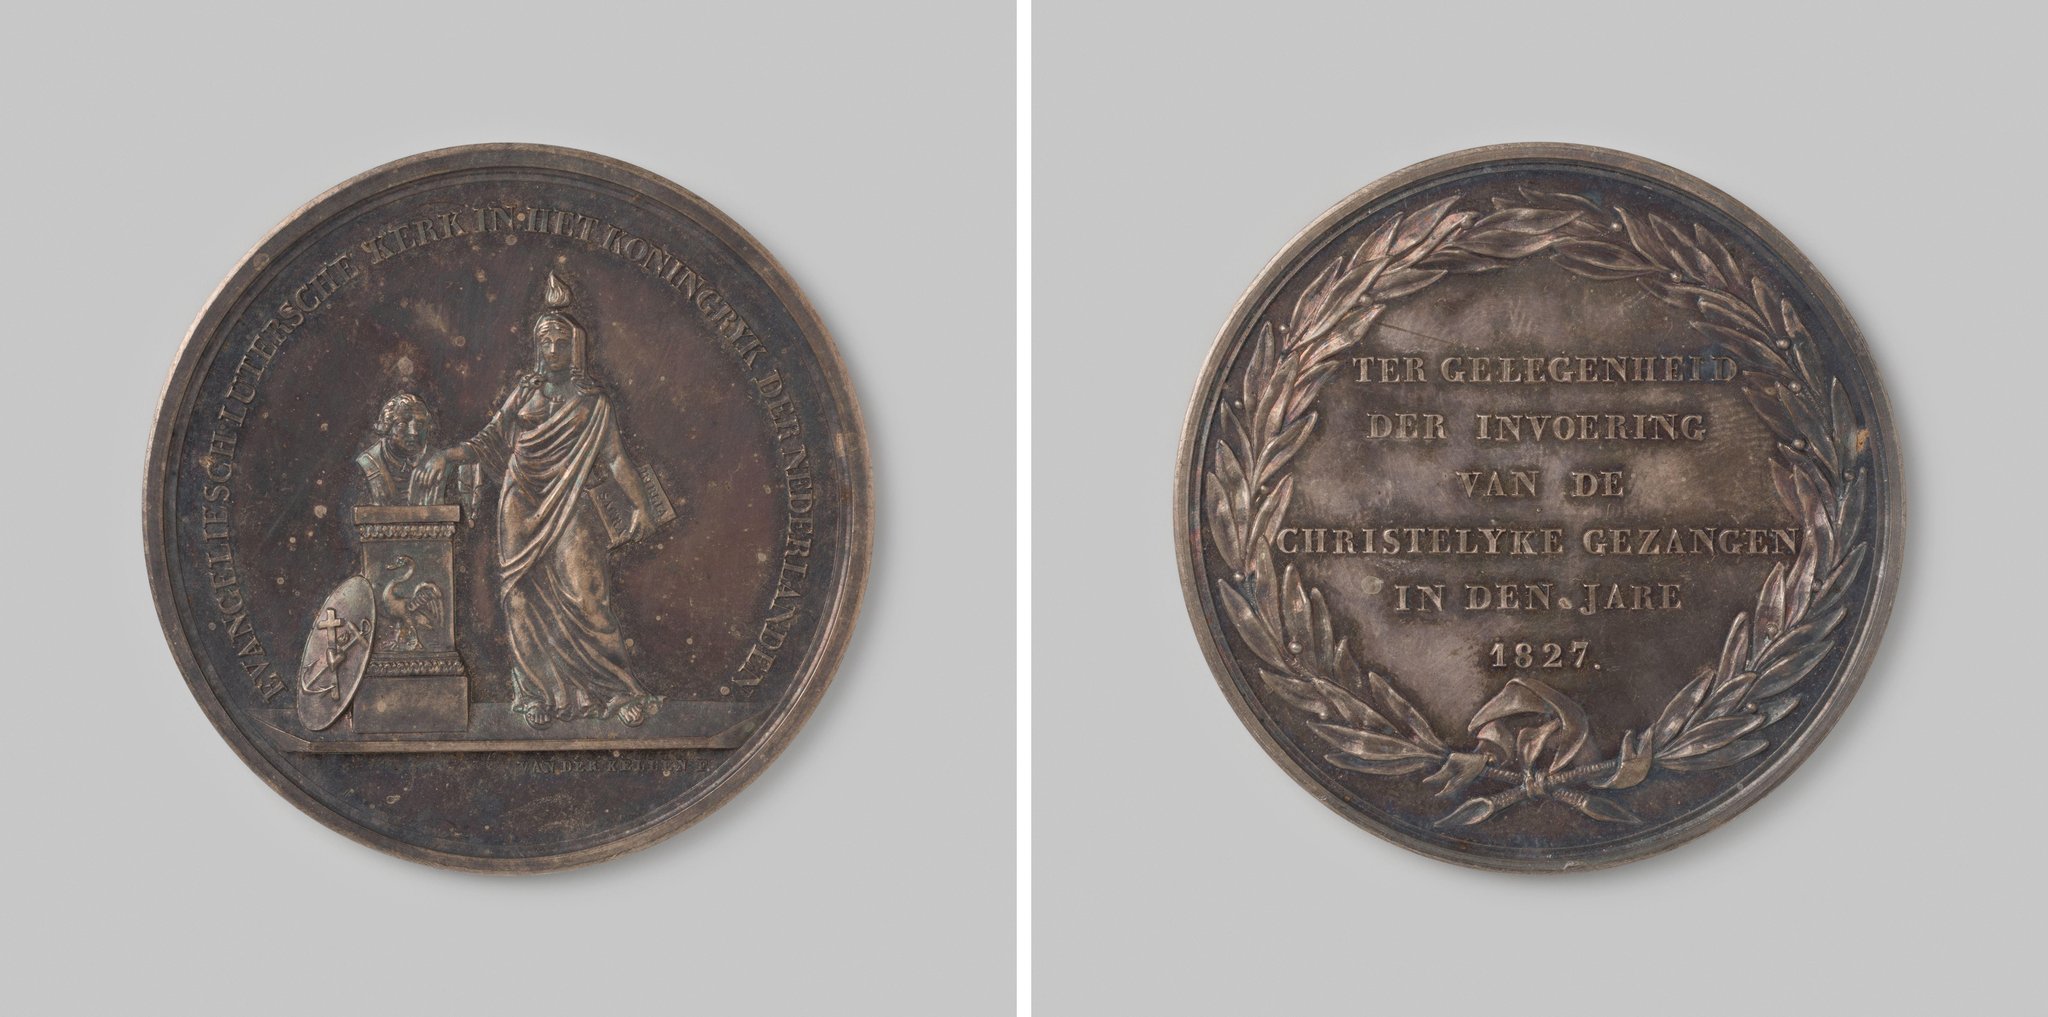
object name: history medal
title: Invoering van de nieuwe gezangen in de Evangelisch Luthersche Kerk 1827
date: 1827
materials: silver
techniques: striking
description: Zilveren penning, op de voorzijde de Godsdienst als gesluierde vrouw met bijbel, de rechterhand op een borstbeeld van Maarten Luther staand op een zuil, met omschrift, op de keerzijde zes regels tekst tussen samengestrikte lauwertakken.